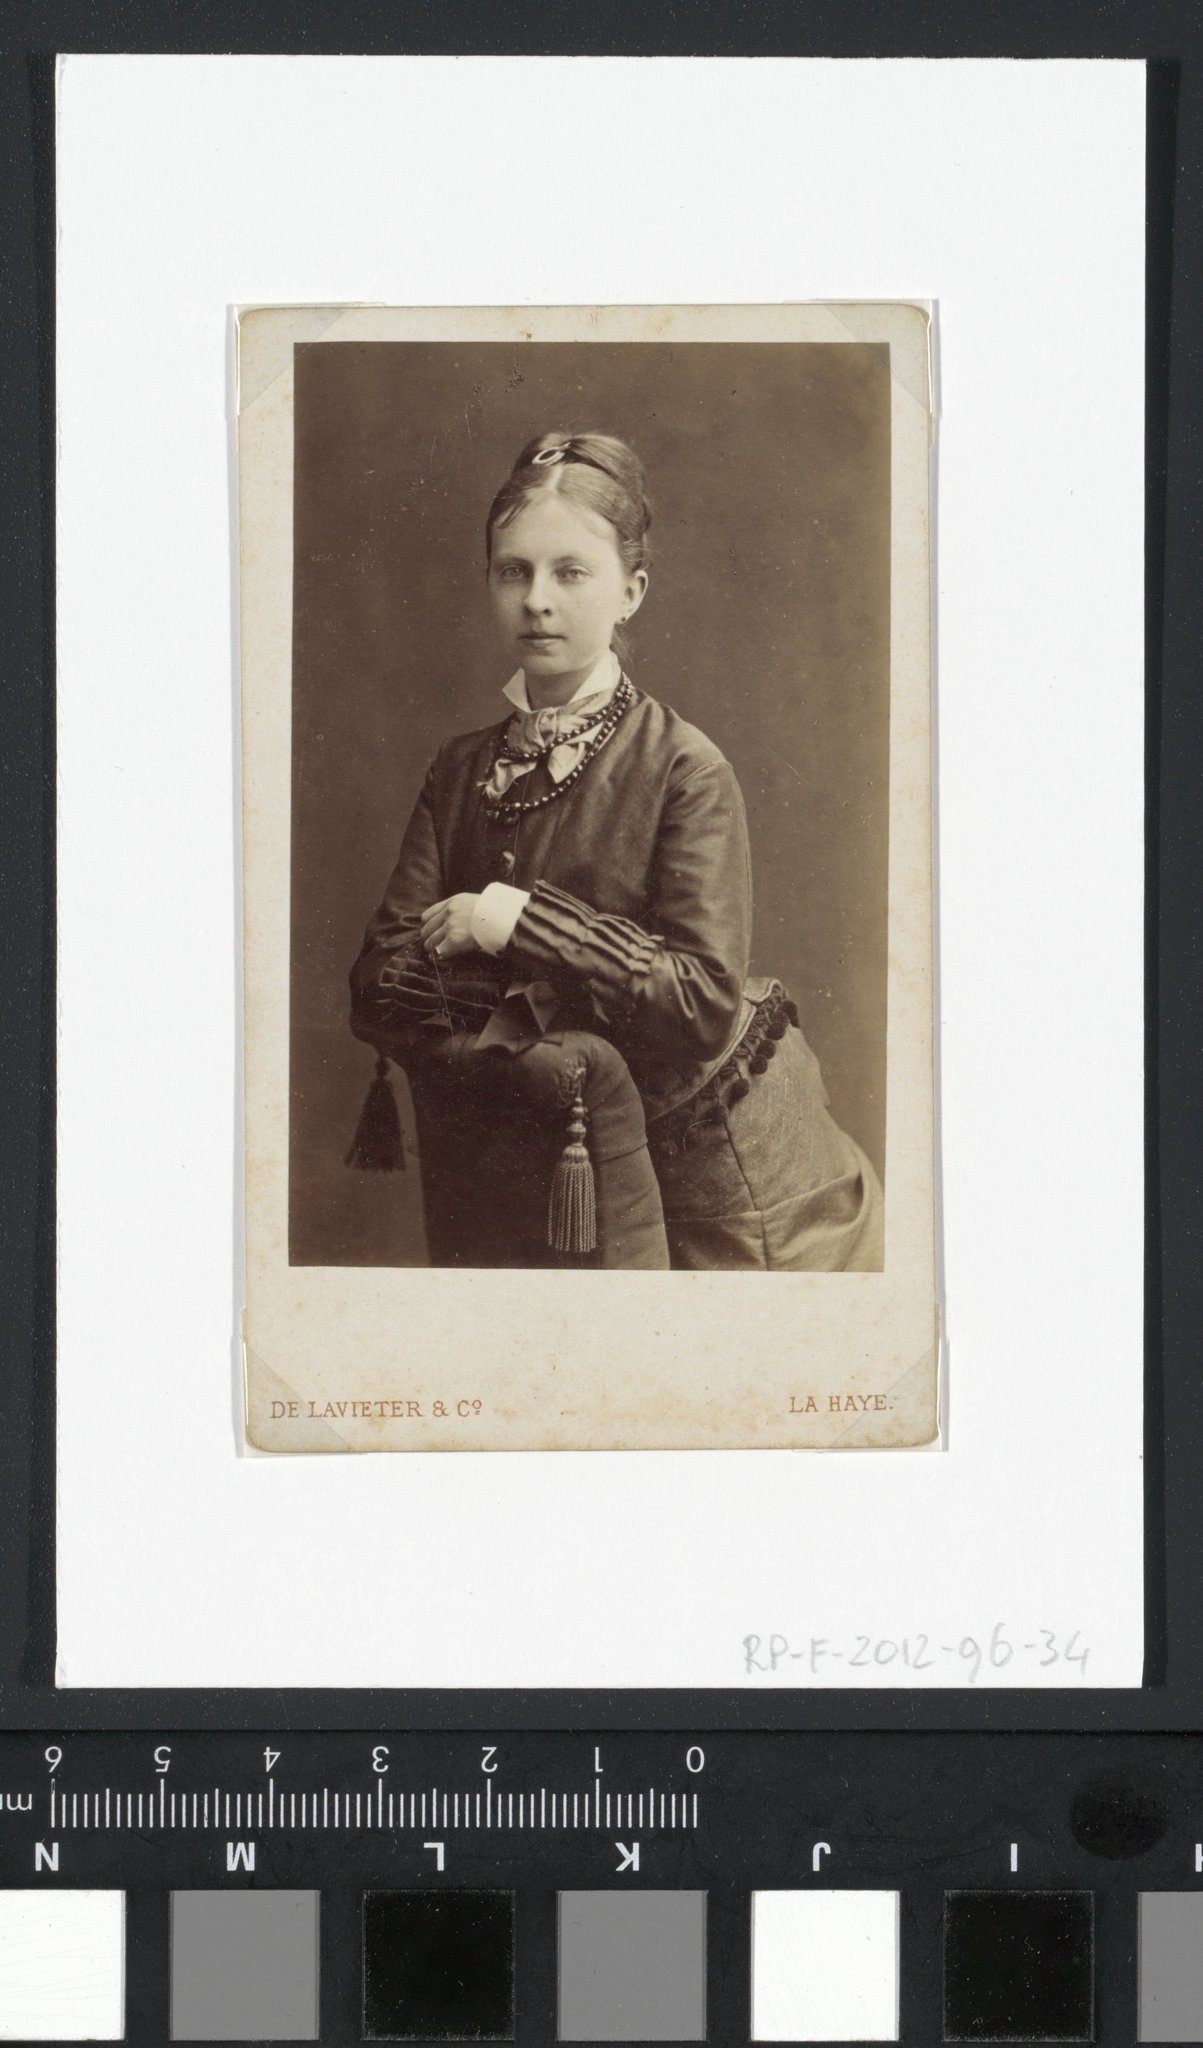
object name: carte de visite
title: Portret van een vrouw, leunend op een fauteuil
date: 1865-1903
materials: cardboard, paper, photographic support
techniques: albumen print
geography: the hague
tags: studio requisites ~ photographer, historical persons not known by name - bb - woman, the hague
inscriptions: address: ‘Willemstraat No. 2 La Haye’